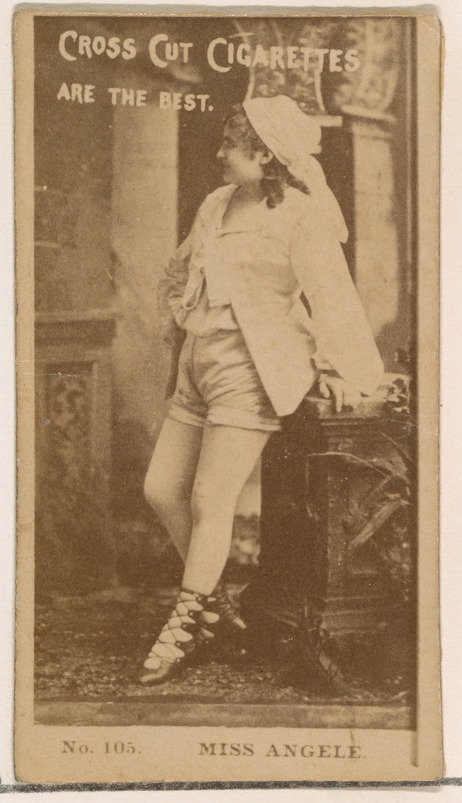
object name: print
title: Card Number 105, Miss Angele, from the Actors and Actresses series (N145-2) issued by Duke Sons & Co. to promote Cross Cut Cigarettes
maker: w. duke, sons & co.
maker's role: publisher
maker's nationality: american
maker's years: 1870-1920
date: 1880-1889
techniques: albumen silver print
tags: profiles,women,actresses